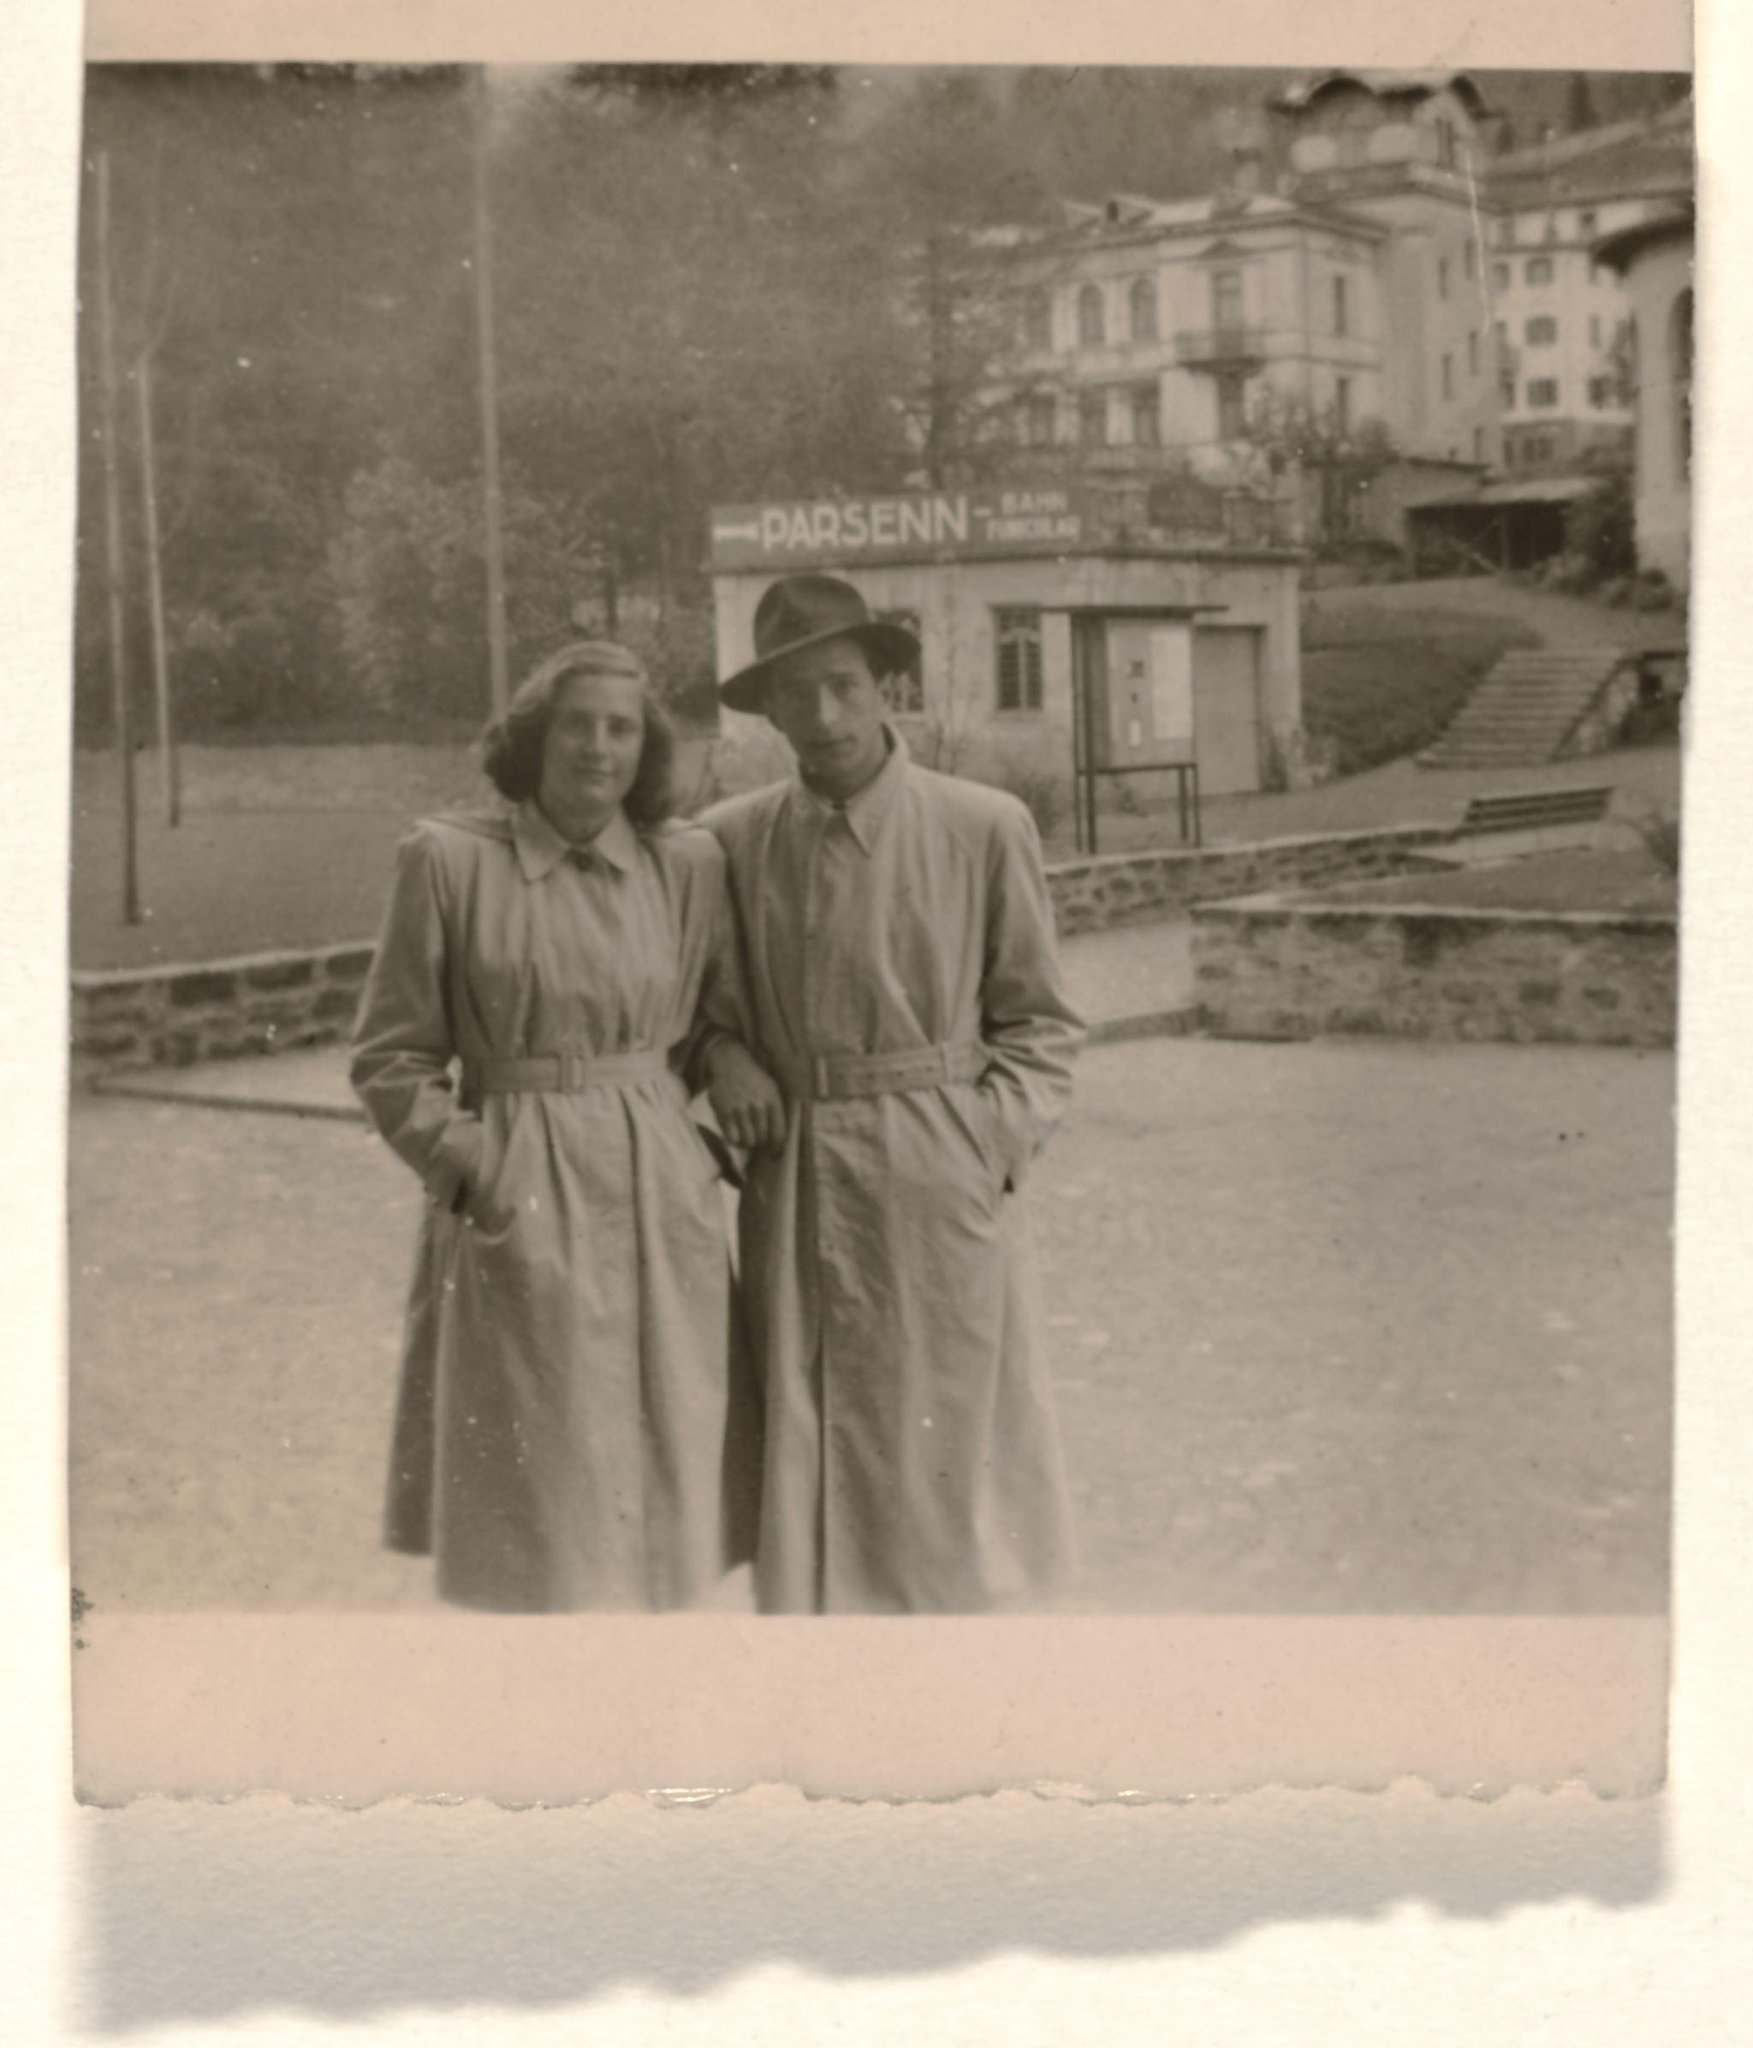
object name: photograph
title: Leo Blumensohn en Isabel Wachenheimer in lange jassen, staand voor Parssen en witte gebouwen, Davos 1946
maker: Anonymous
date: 1945-1949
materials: photographic support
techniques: gelatin silver print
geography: davos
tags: leiden, isabel wachenheimer-elon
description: Leo Blumensohn en Isabel Wachenheimer gezeten op een motor, staand voor een hek en een begroeide helling.